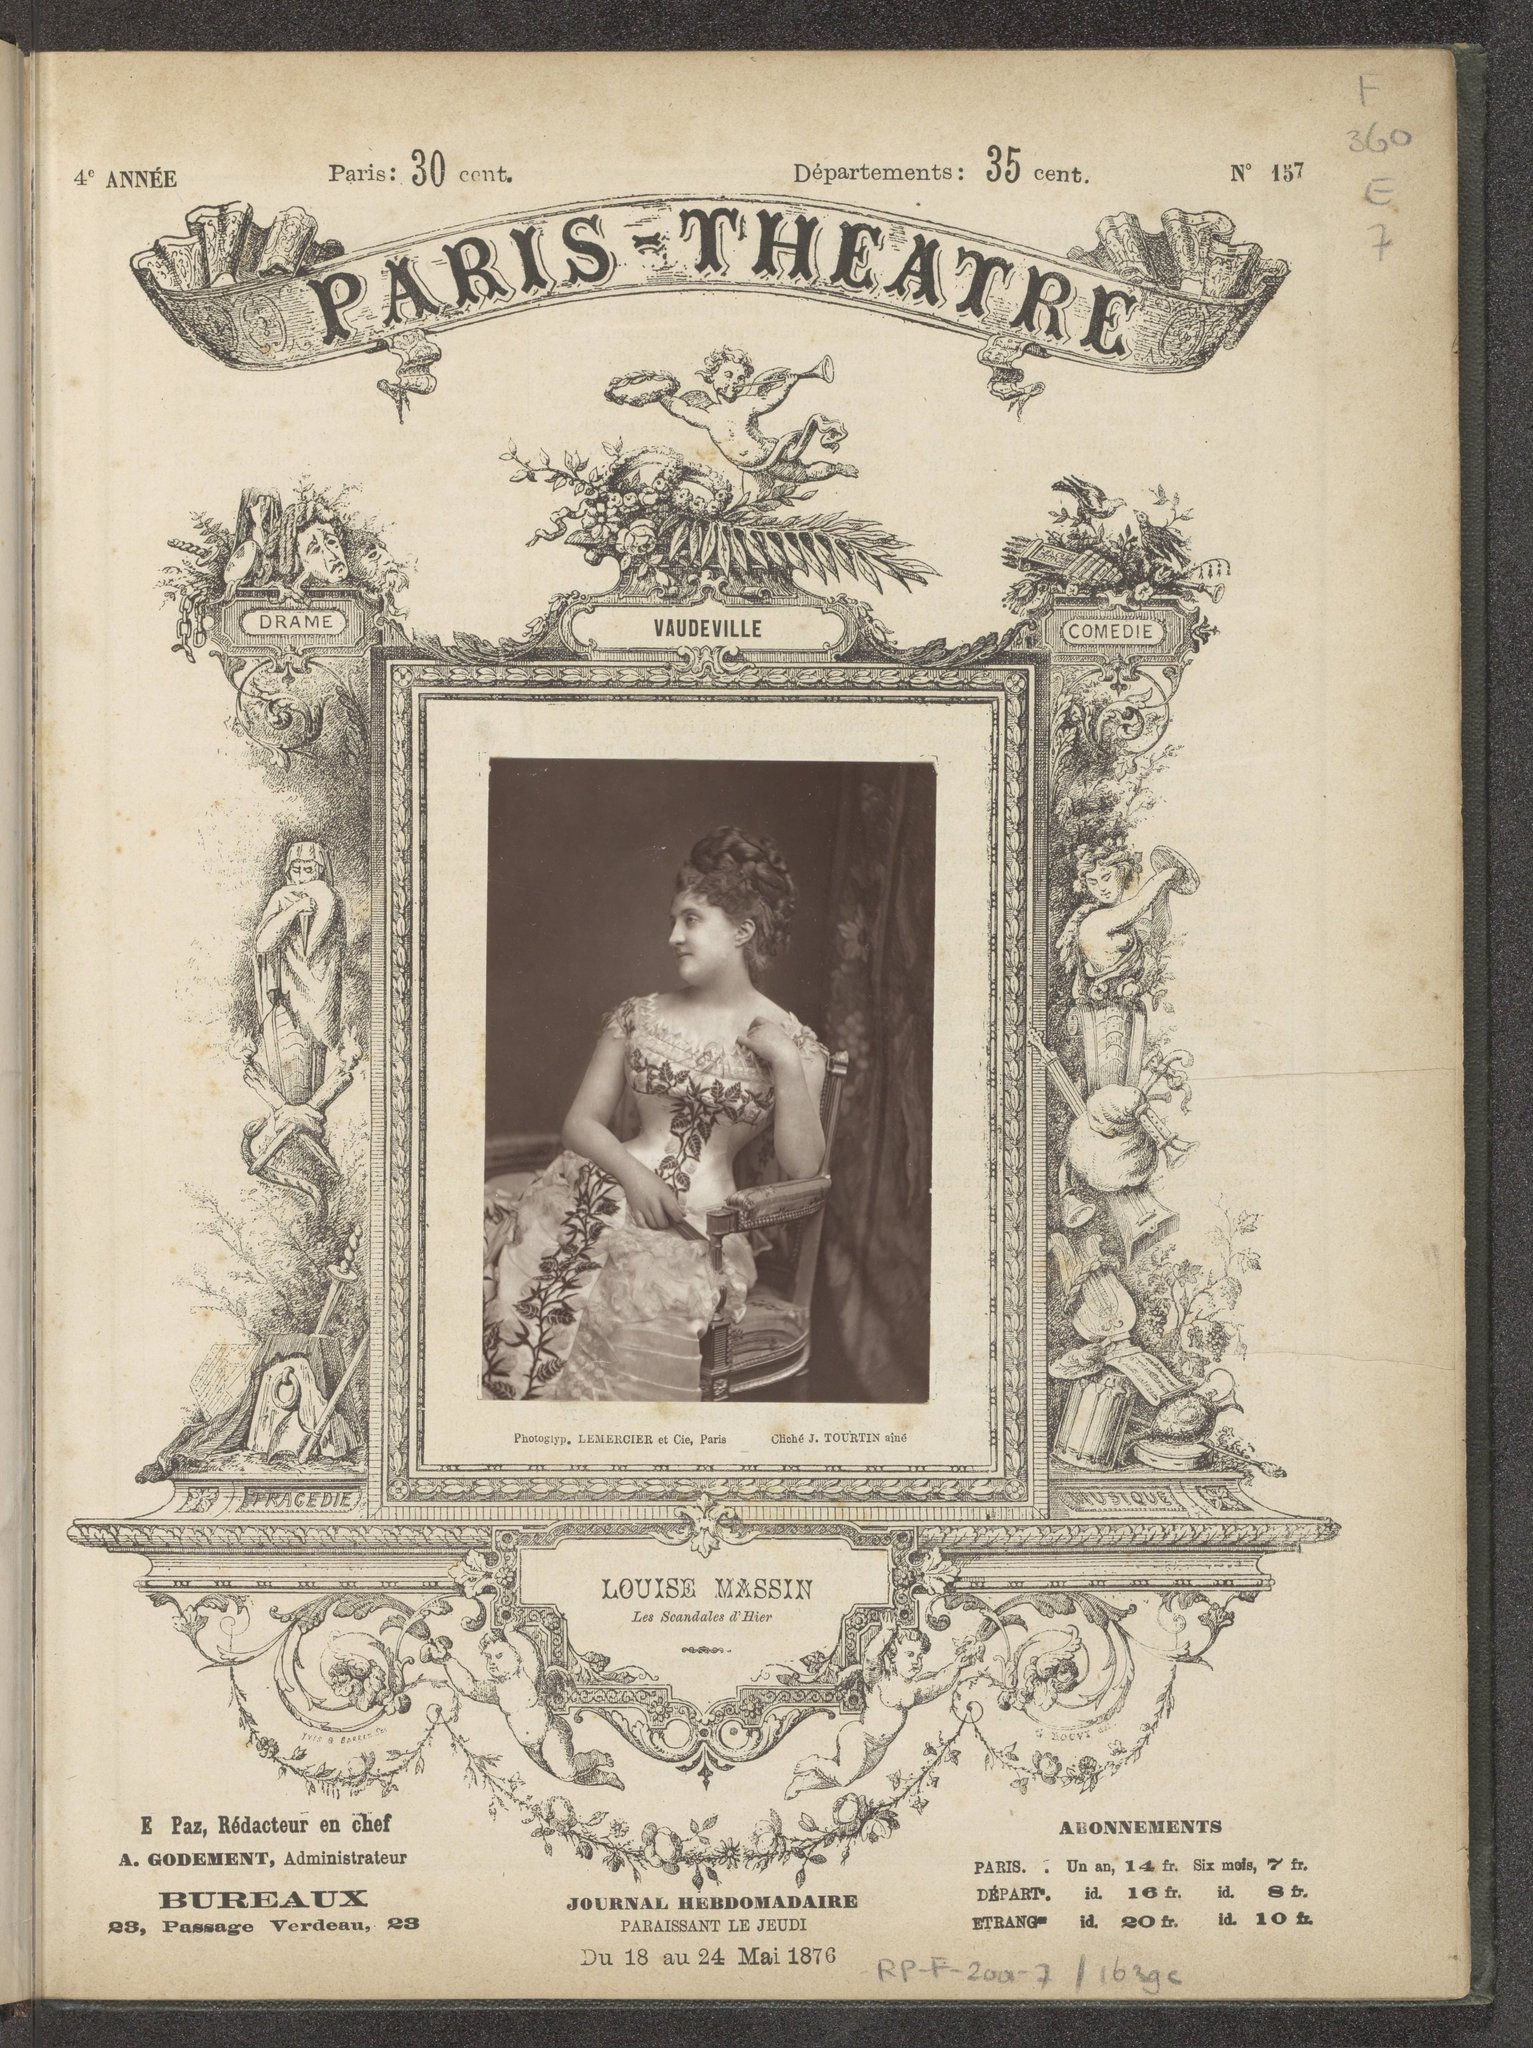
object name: photomechanical print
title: Louise Massin Les Scandales d'Hier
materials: paper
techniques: woodburytype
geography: france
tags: portrait of actor, actress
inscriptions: inscription: ‘Journal hebdomadaire paraissant le jeudi Du 18 au 24 Mai 1876’, number: ‘No 157’